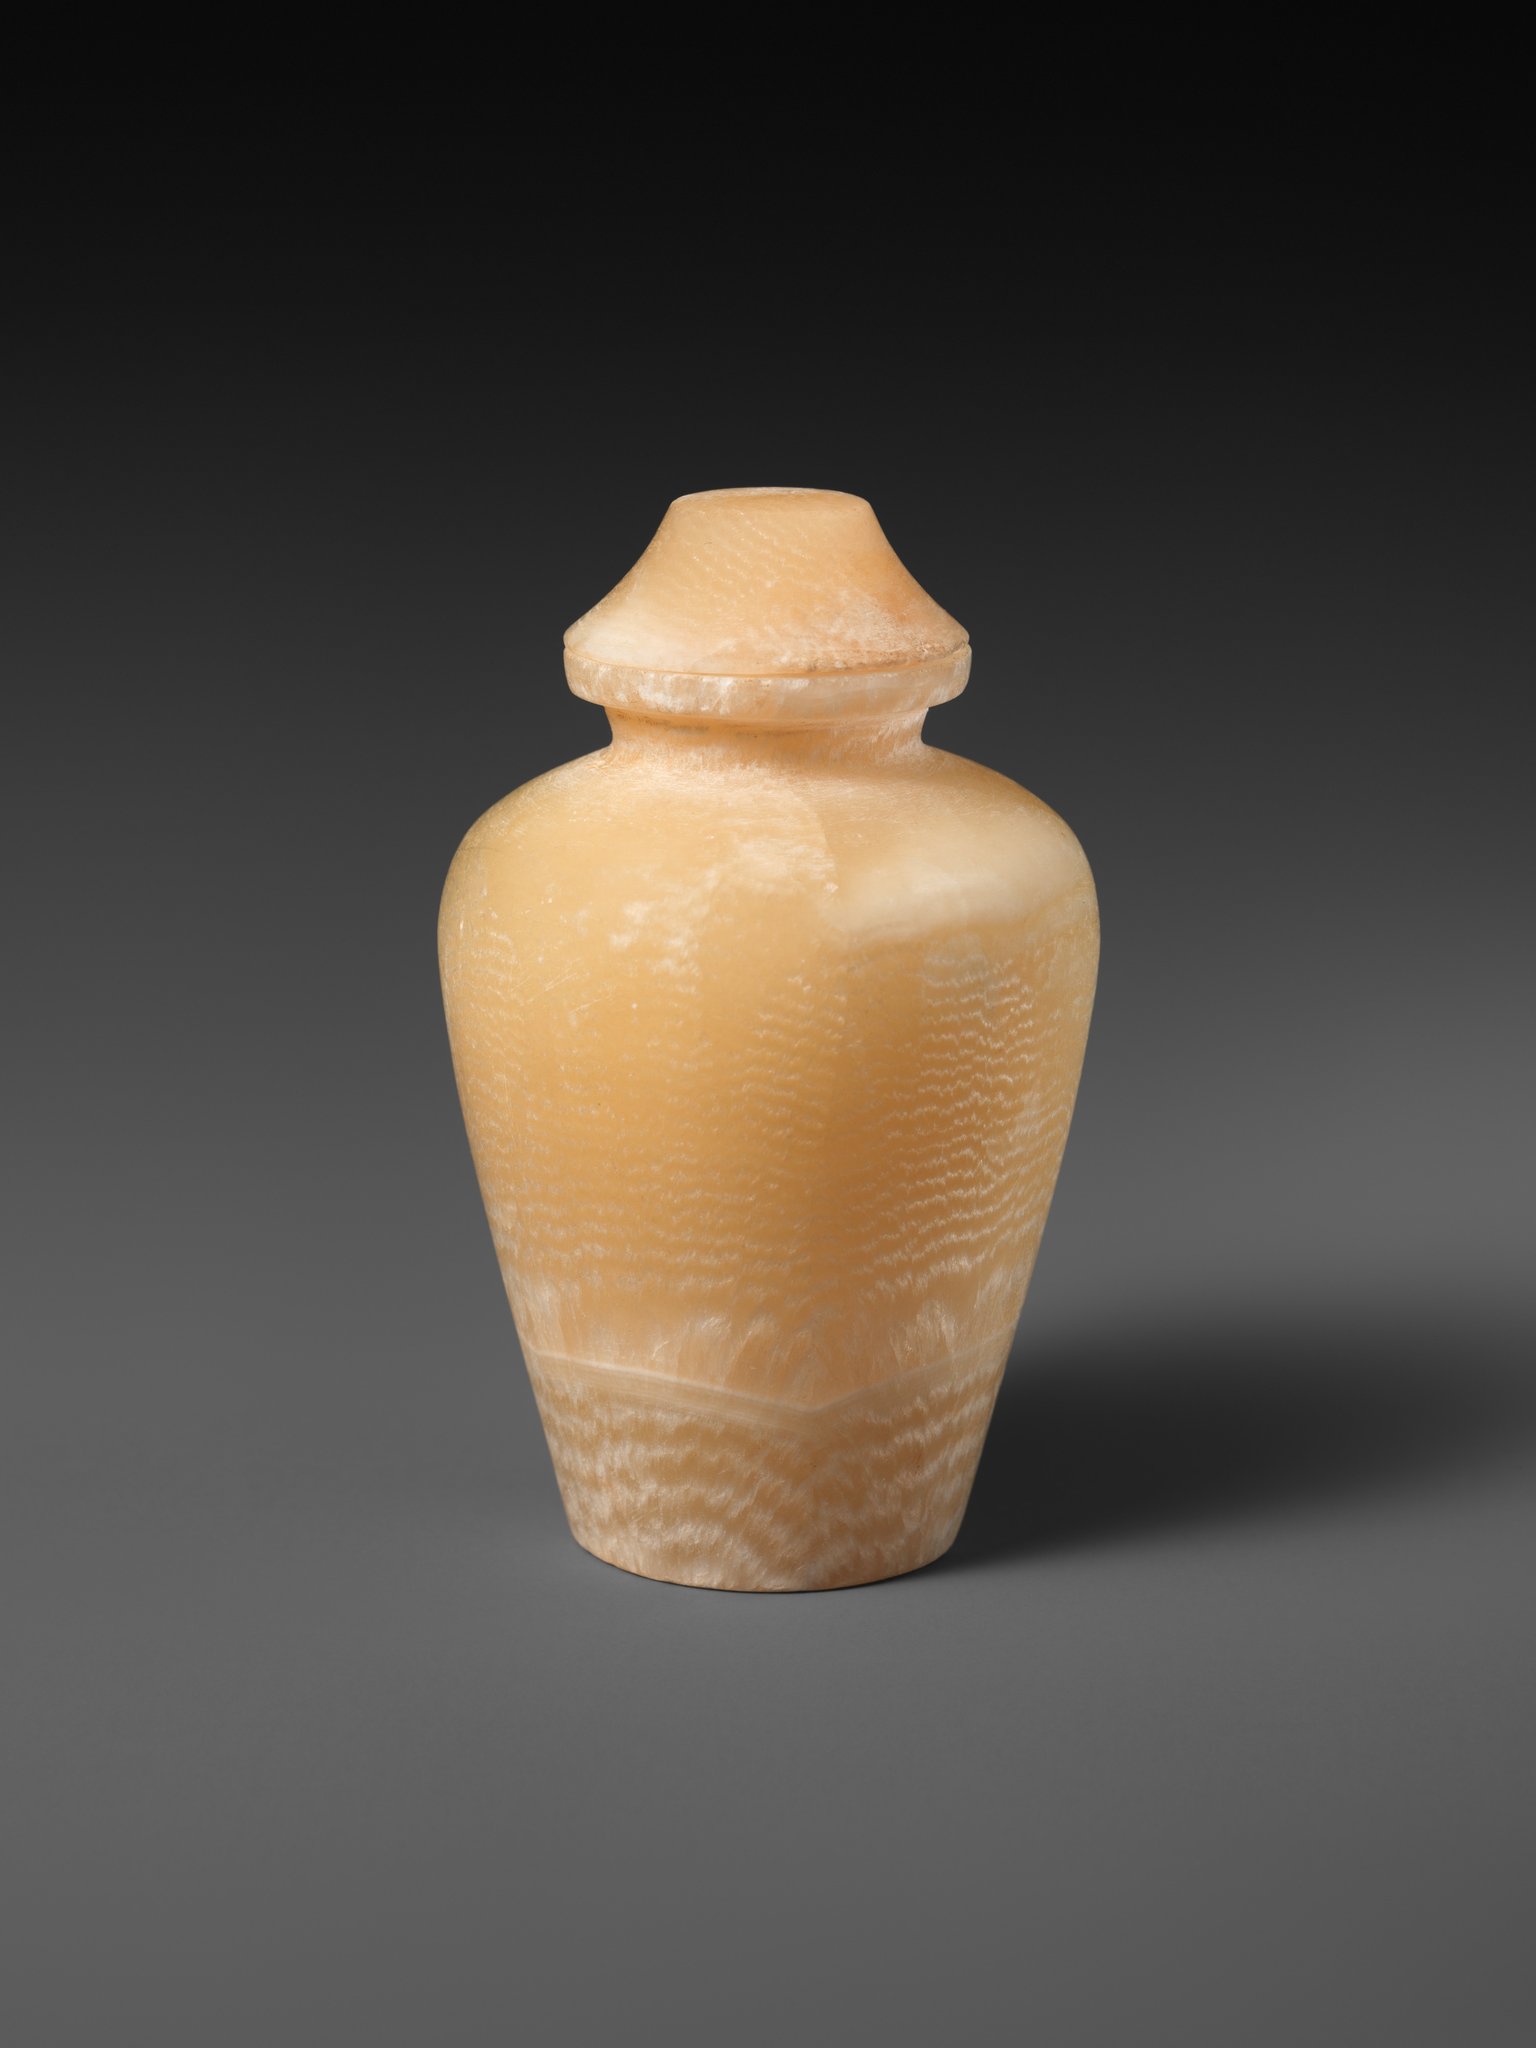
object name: libation jar with lid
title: Libation jar with with lid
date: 1887-1750 BCE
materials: stone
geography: egypt